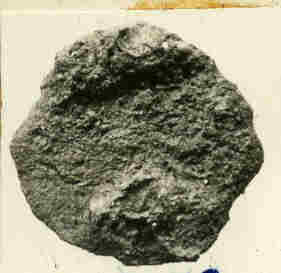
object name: coin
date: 401-1400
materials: copper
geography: iran